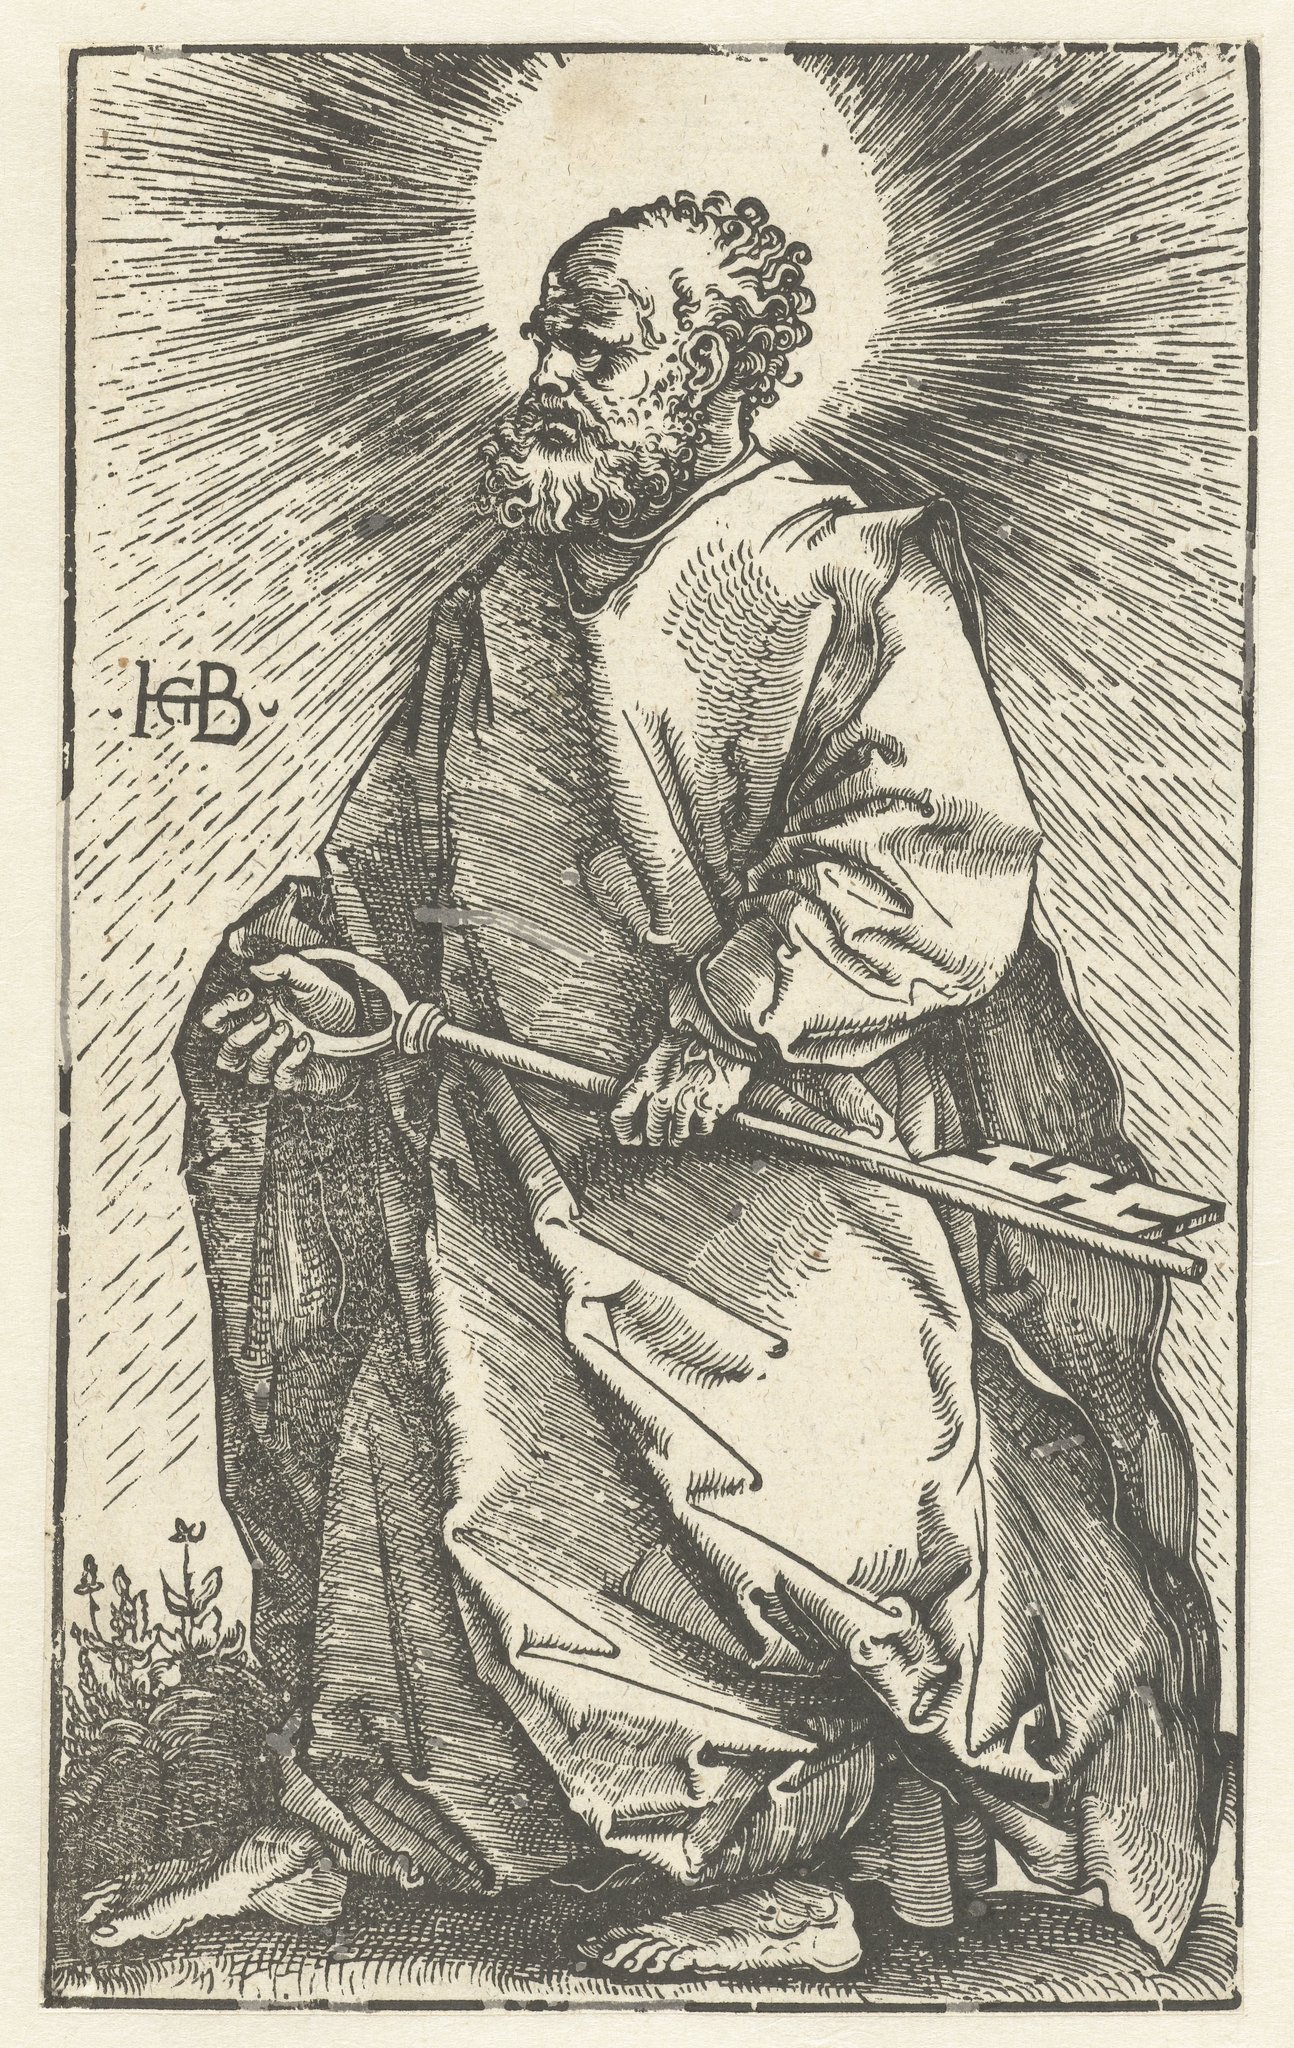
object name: print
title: Christus en de Apostelen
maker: hans baldung grien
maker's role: draughtsman, print maker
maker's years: 1484-1545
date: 1519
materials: paper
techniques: woodcut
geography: straatsburg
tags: the apostle peter, first bishop of rome; possible attributes: book, cock, (upturned) cross, (triple) crozier, fish, key, scroll, ship, tiara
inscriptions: collector's mark: Lugt 240